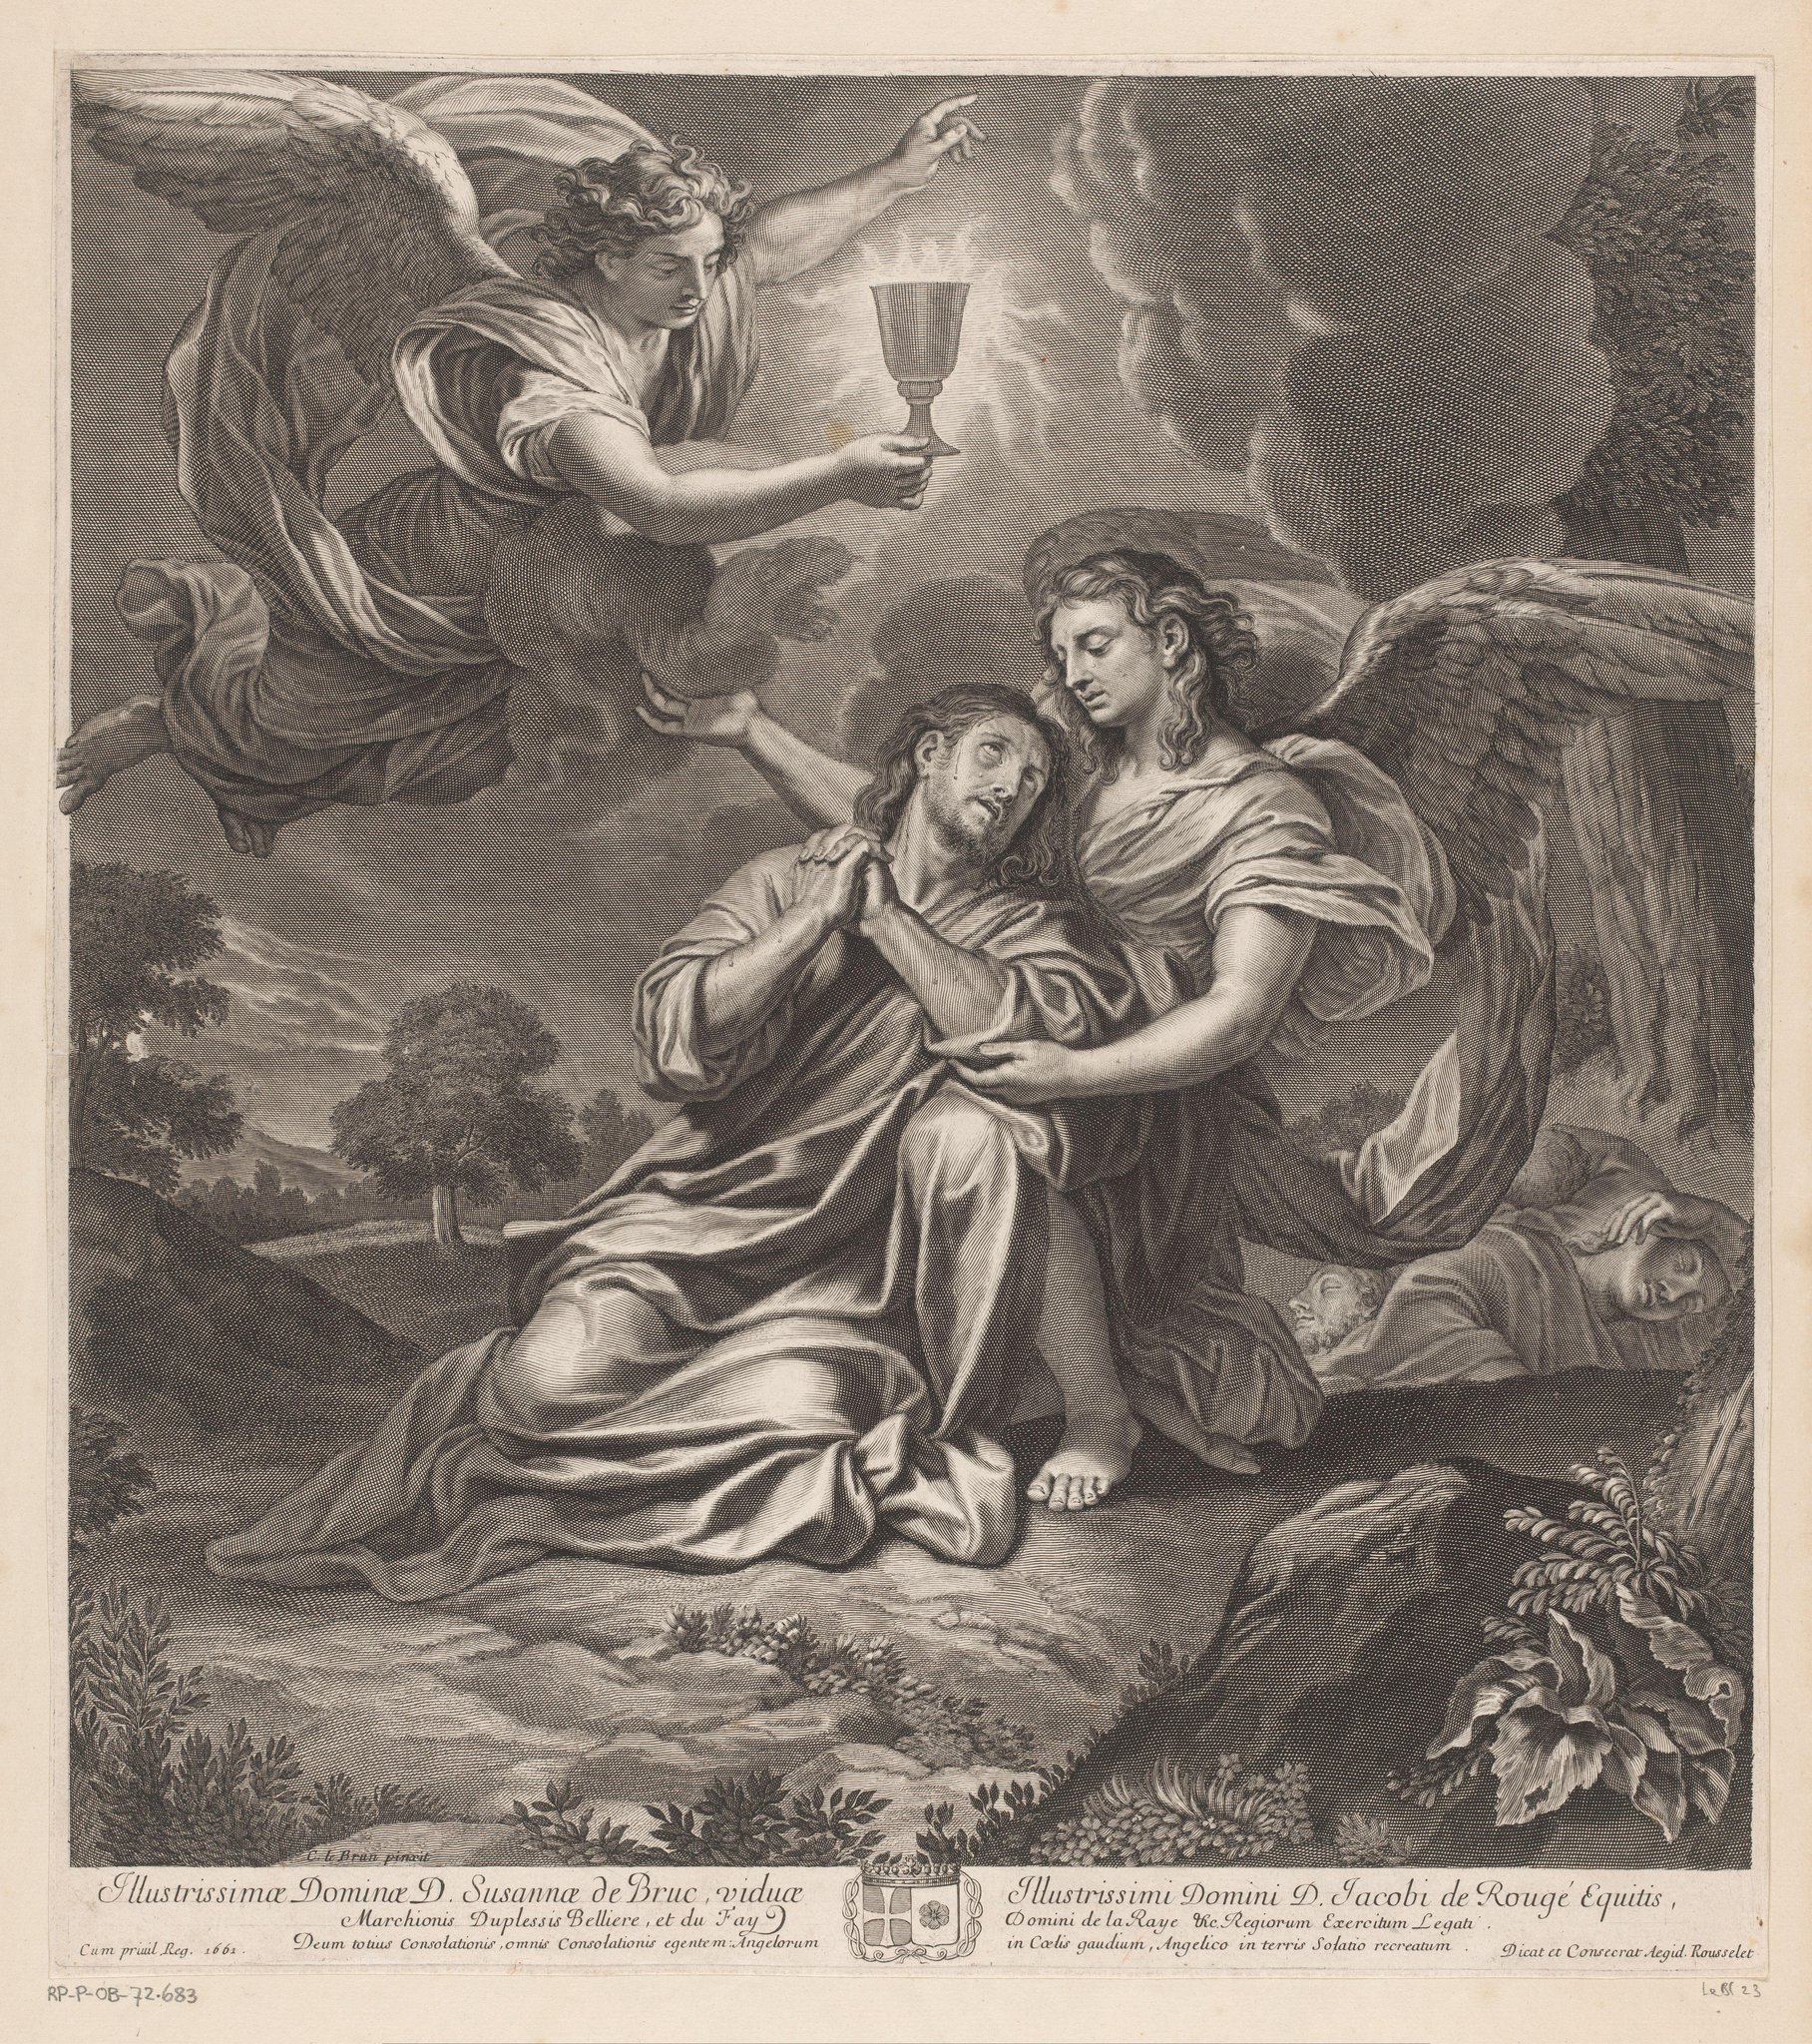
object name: print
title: Christus in de hof van Getsemane met twee engelen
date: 1661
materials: paper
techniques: engraving, etching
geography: france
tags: christ and his apostles on the mount of olives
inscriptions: collector's mark: Lugt 240